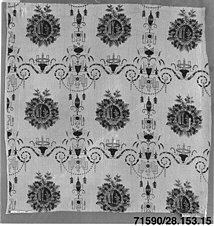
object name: fragment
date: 1767-1800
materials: cotton